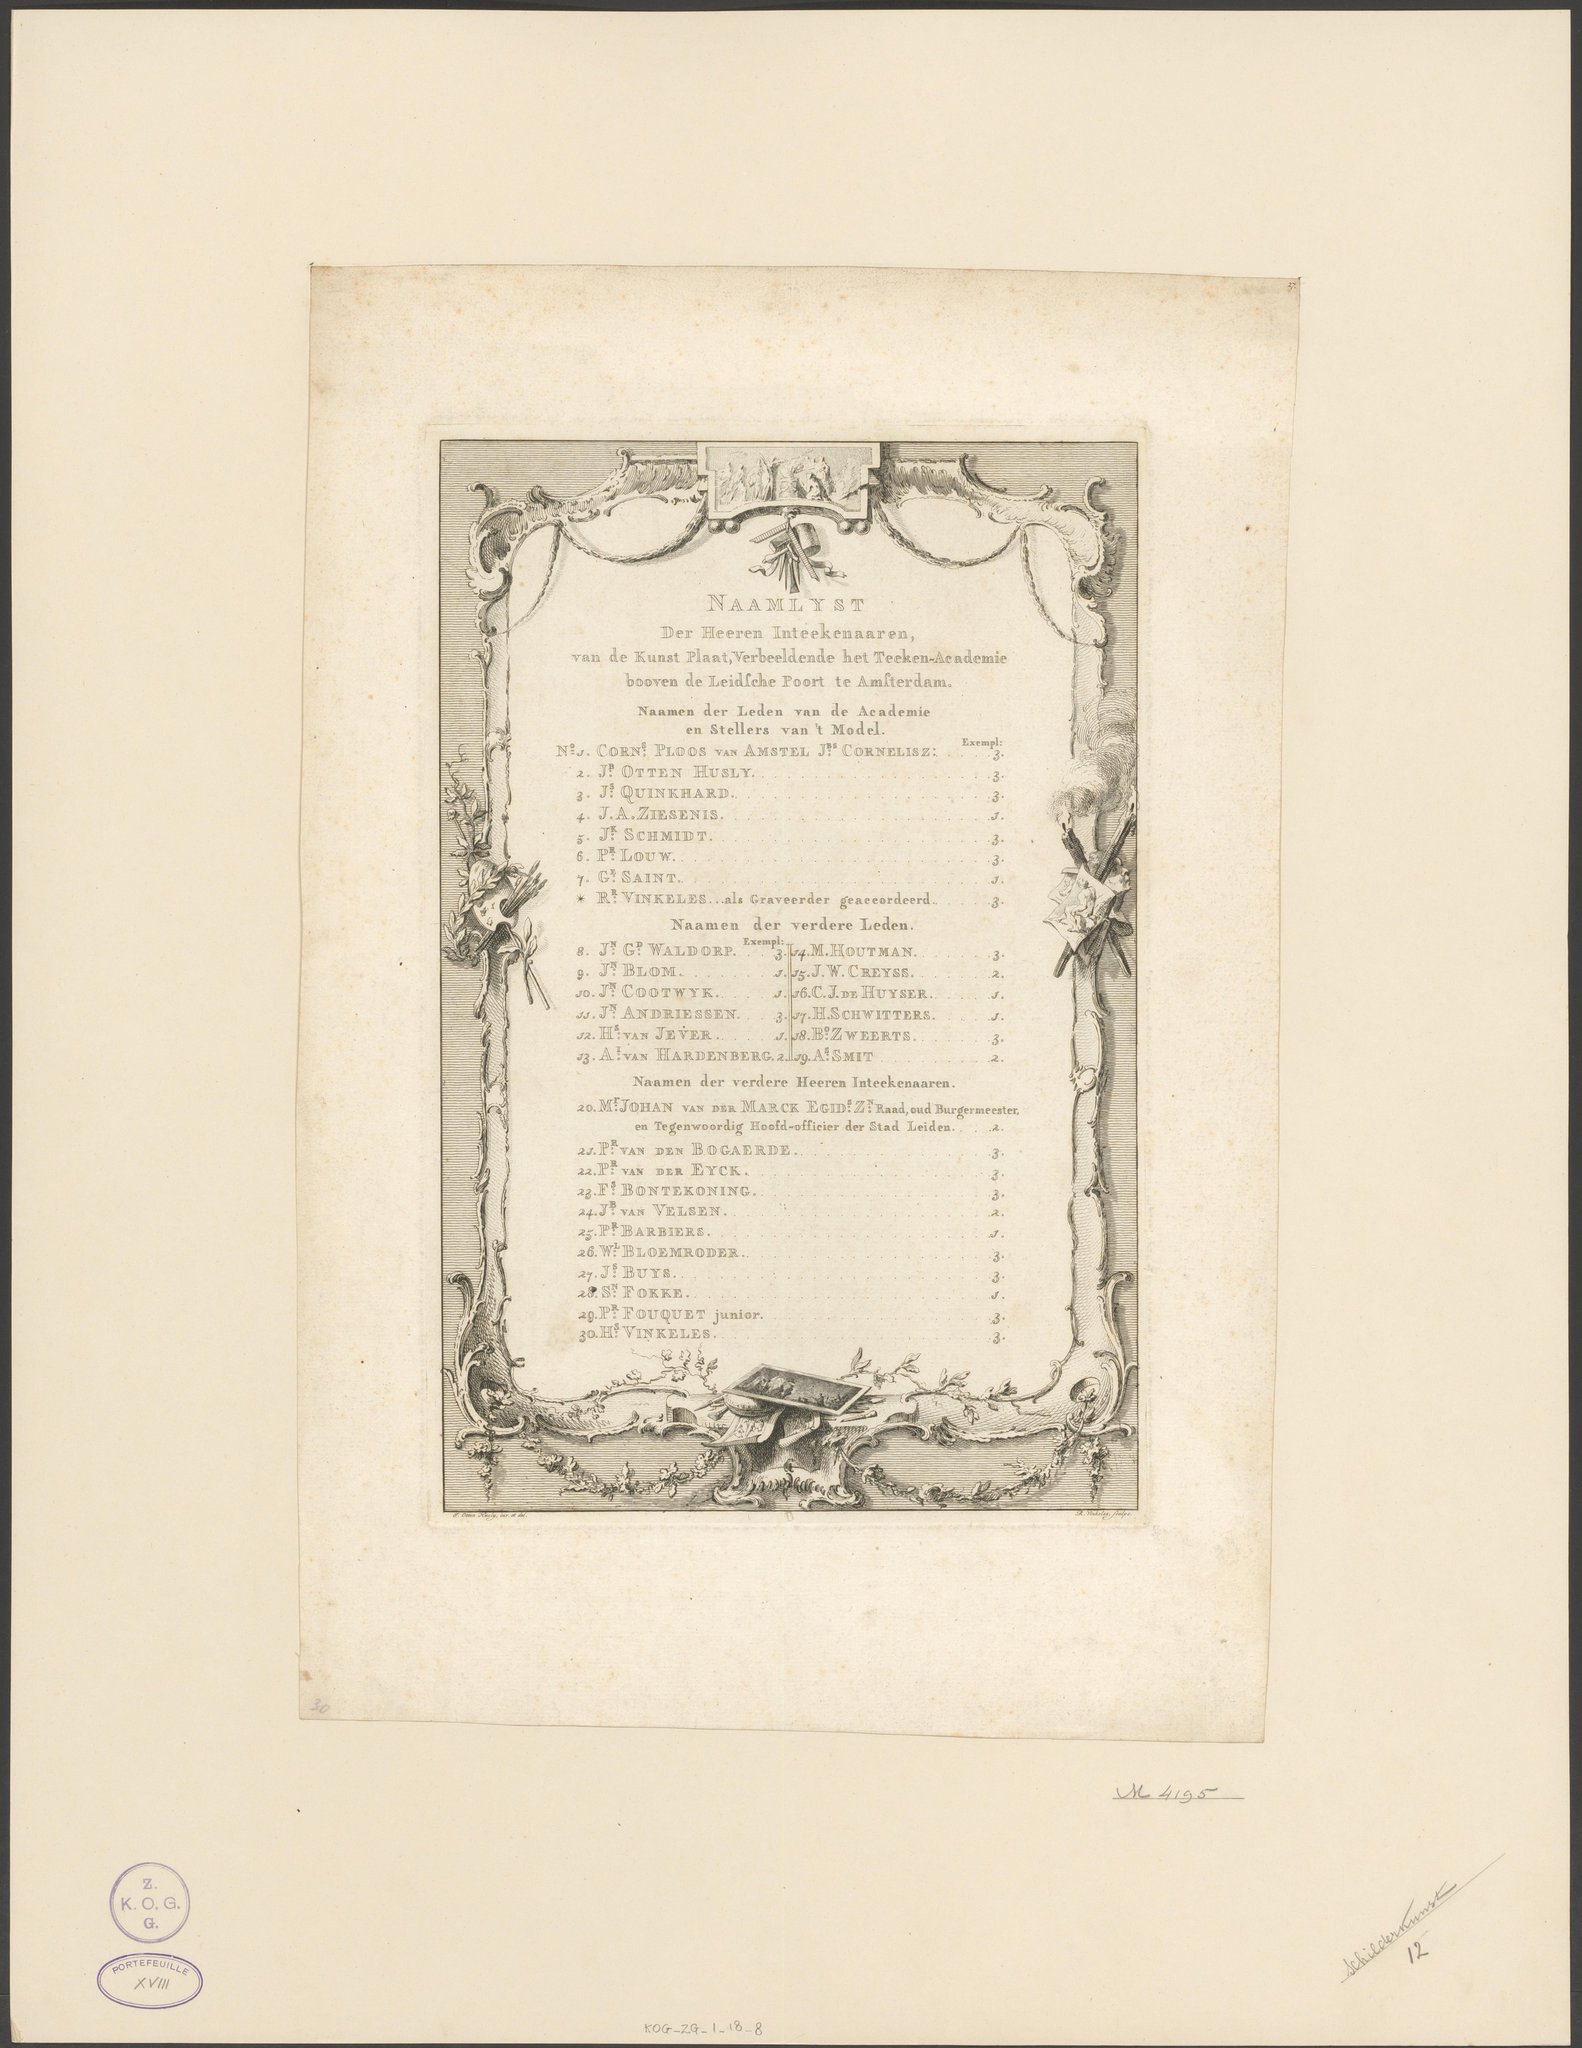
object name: print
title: Naamlyst Der Heeren Inteekenaaren, van de Kunst Plaat, Verbeeldende het Teeken-Academie booven de Leidsche Poort te Amsterdam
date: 1768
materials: paper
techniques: engraving, etching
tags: drawing-lesson, tools, implements of draughtsman, artist at work, in his workshop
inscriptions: collector's mark: Lugt 1641, stamp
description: Cartouche met de namenlijst van de intekenaren op de prent uit 1768 van de stadstekenacademie (Teeken-Academie) boven het Corps de Garde in de Leidsepoort te Amsterdam in het jaar 1764. De namen genummerd 1-30 zijn merendeels leden van de academie, met erbij het aantal prenten waarvoor ingetekend is. Ornamentale omlijsting met rocailles, guirlandes en attributen van de teken- en schilderkunst. Onderwerpsrubrieken binnen de Atlas Zeden en Gewoonten: Schoone kunsten, Schilderkunst, Ateliers.